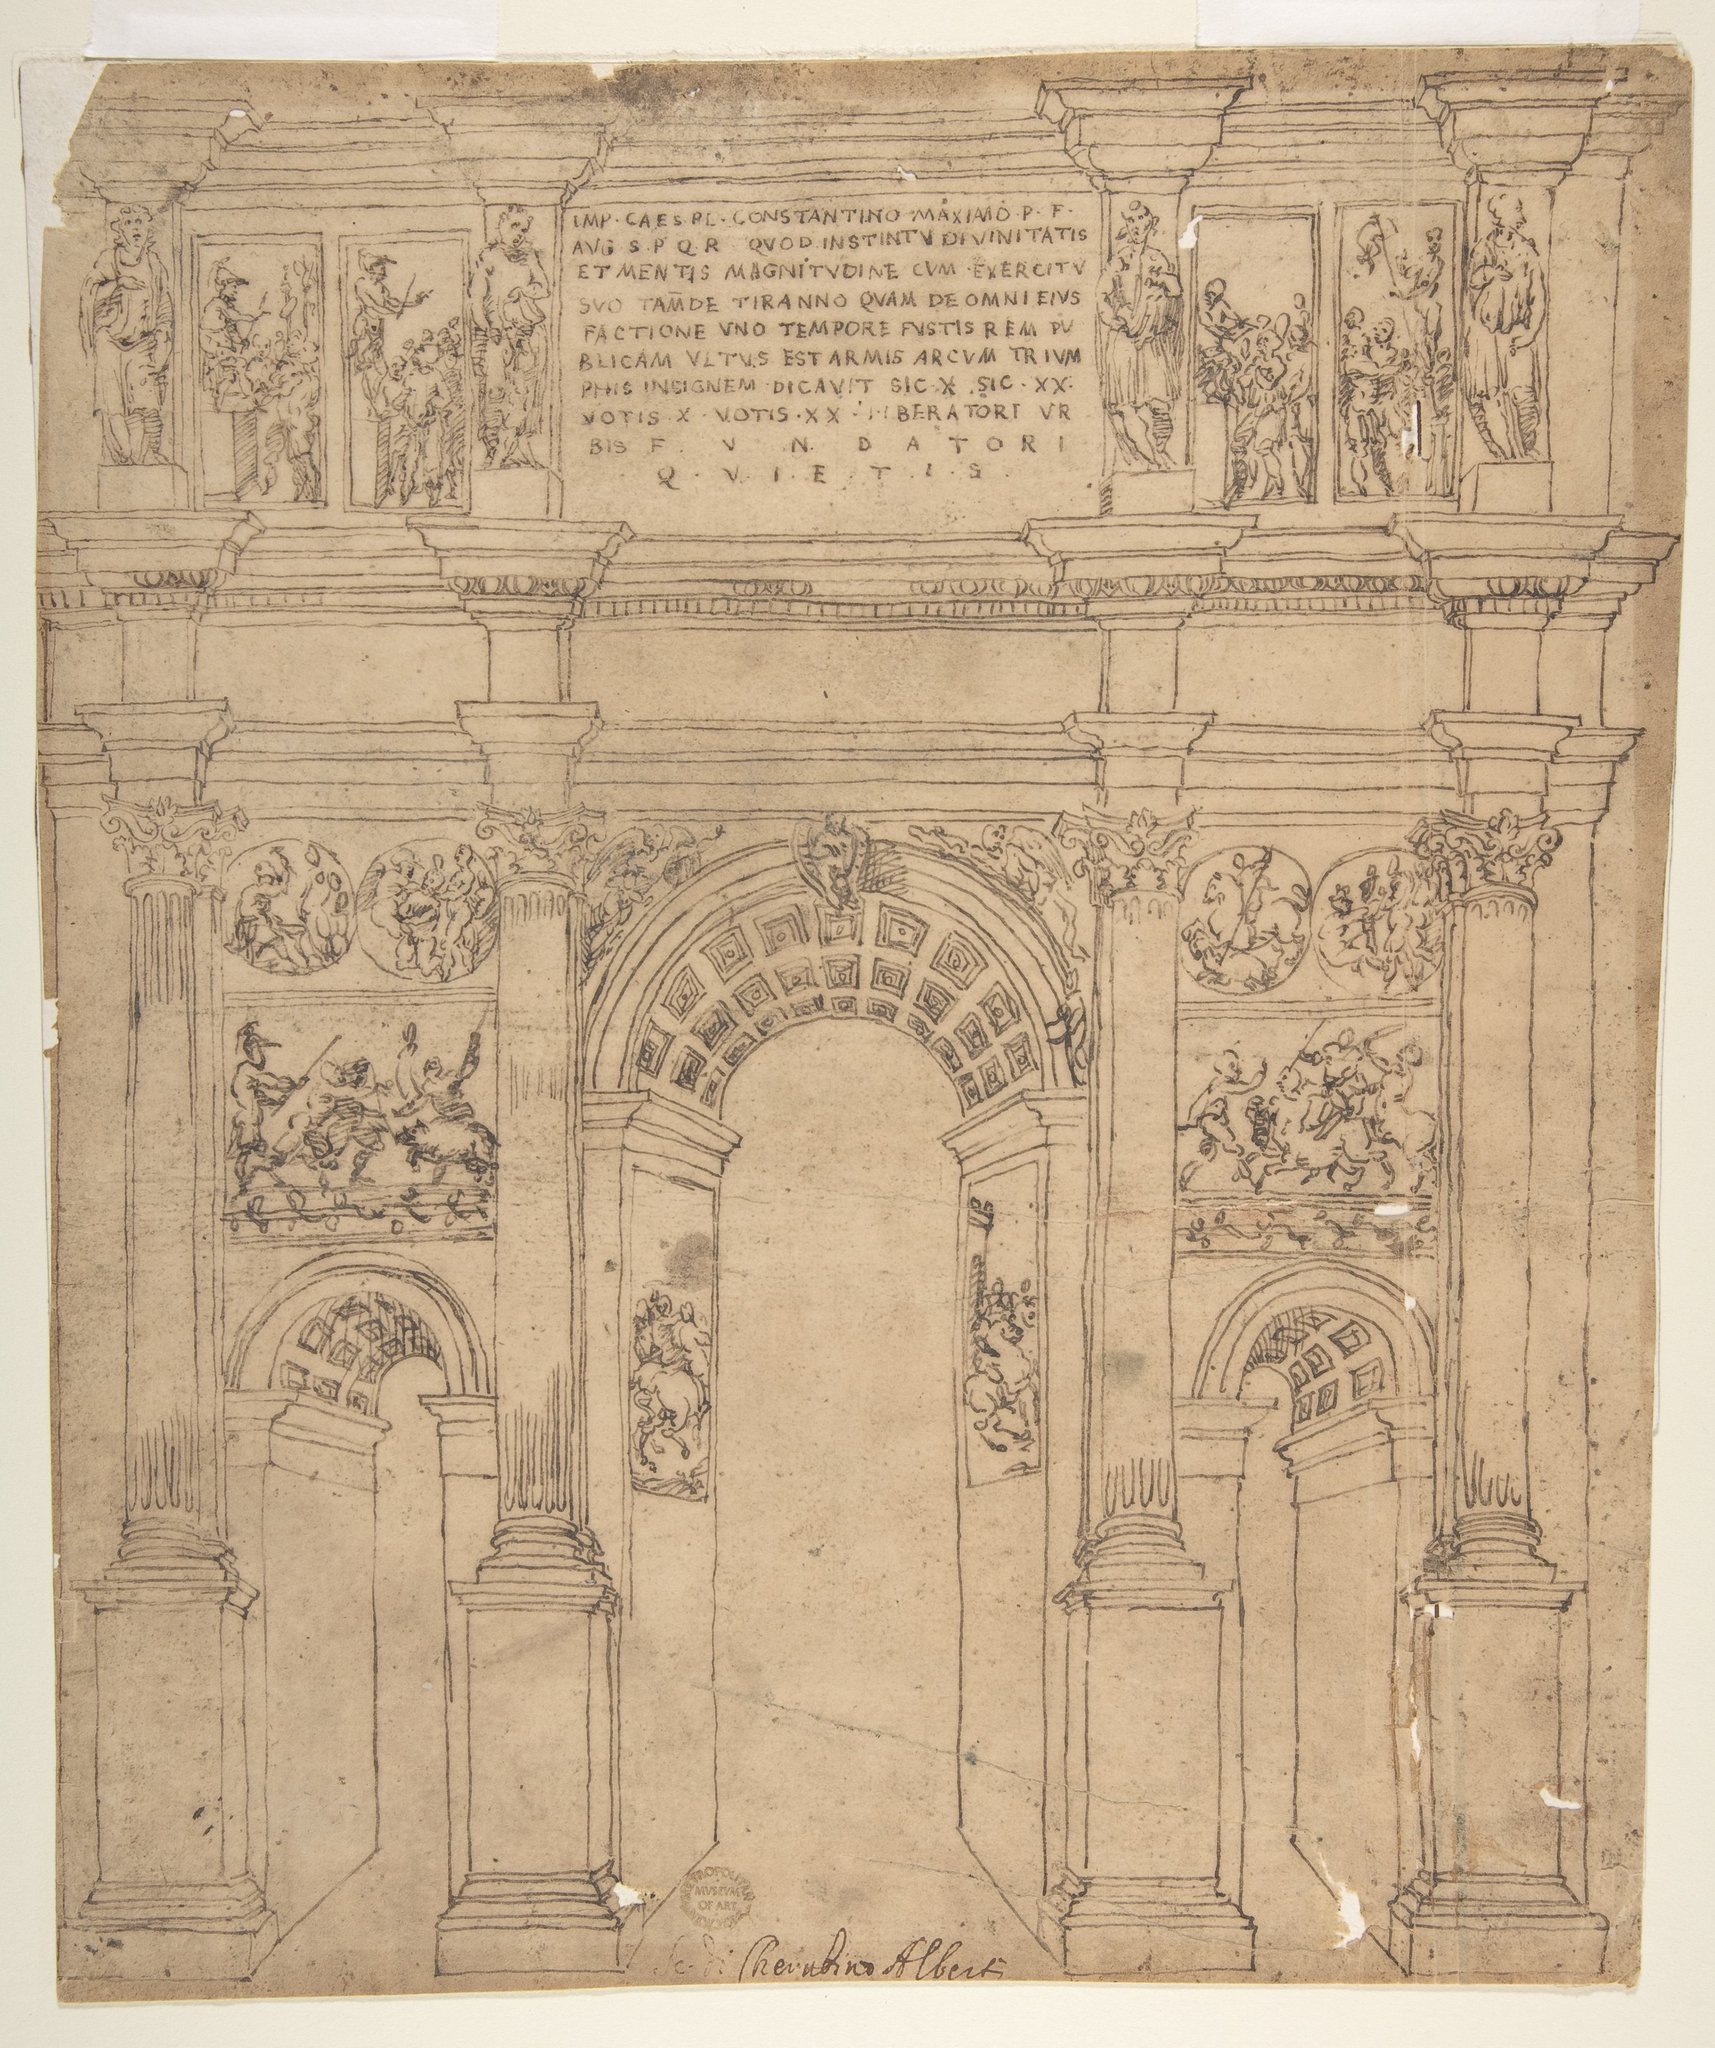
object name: drawing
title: Arch of Constantine, Rome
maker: bartolomeo neroni (il riccio)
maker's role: artist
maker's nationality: italian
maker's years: 1505-1571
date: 1500-1571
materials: ink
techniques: brush, pen, wash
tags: architecture,arches